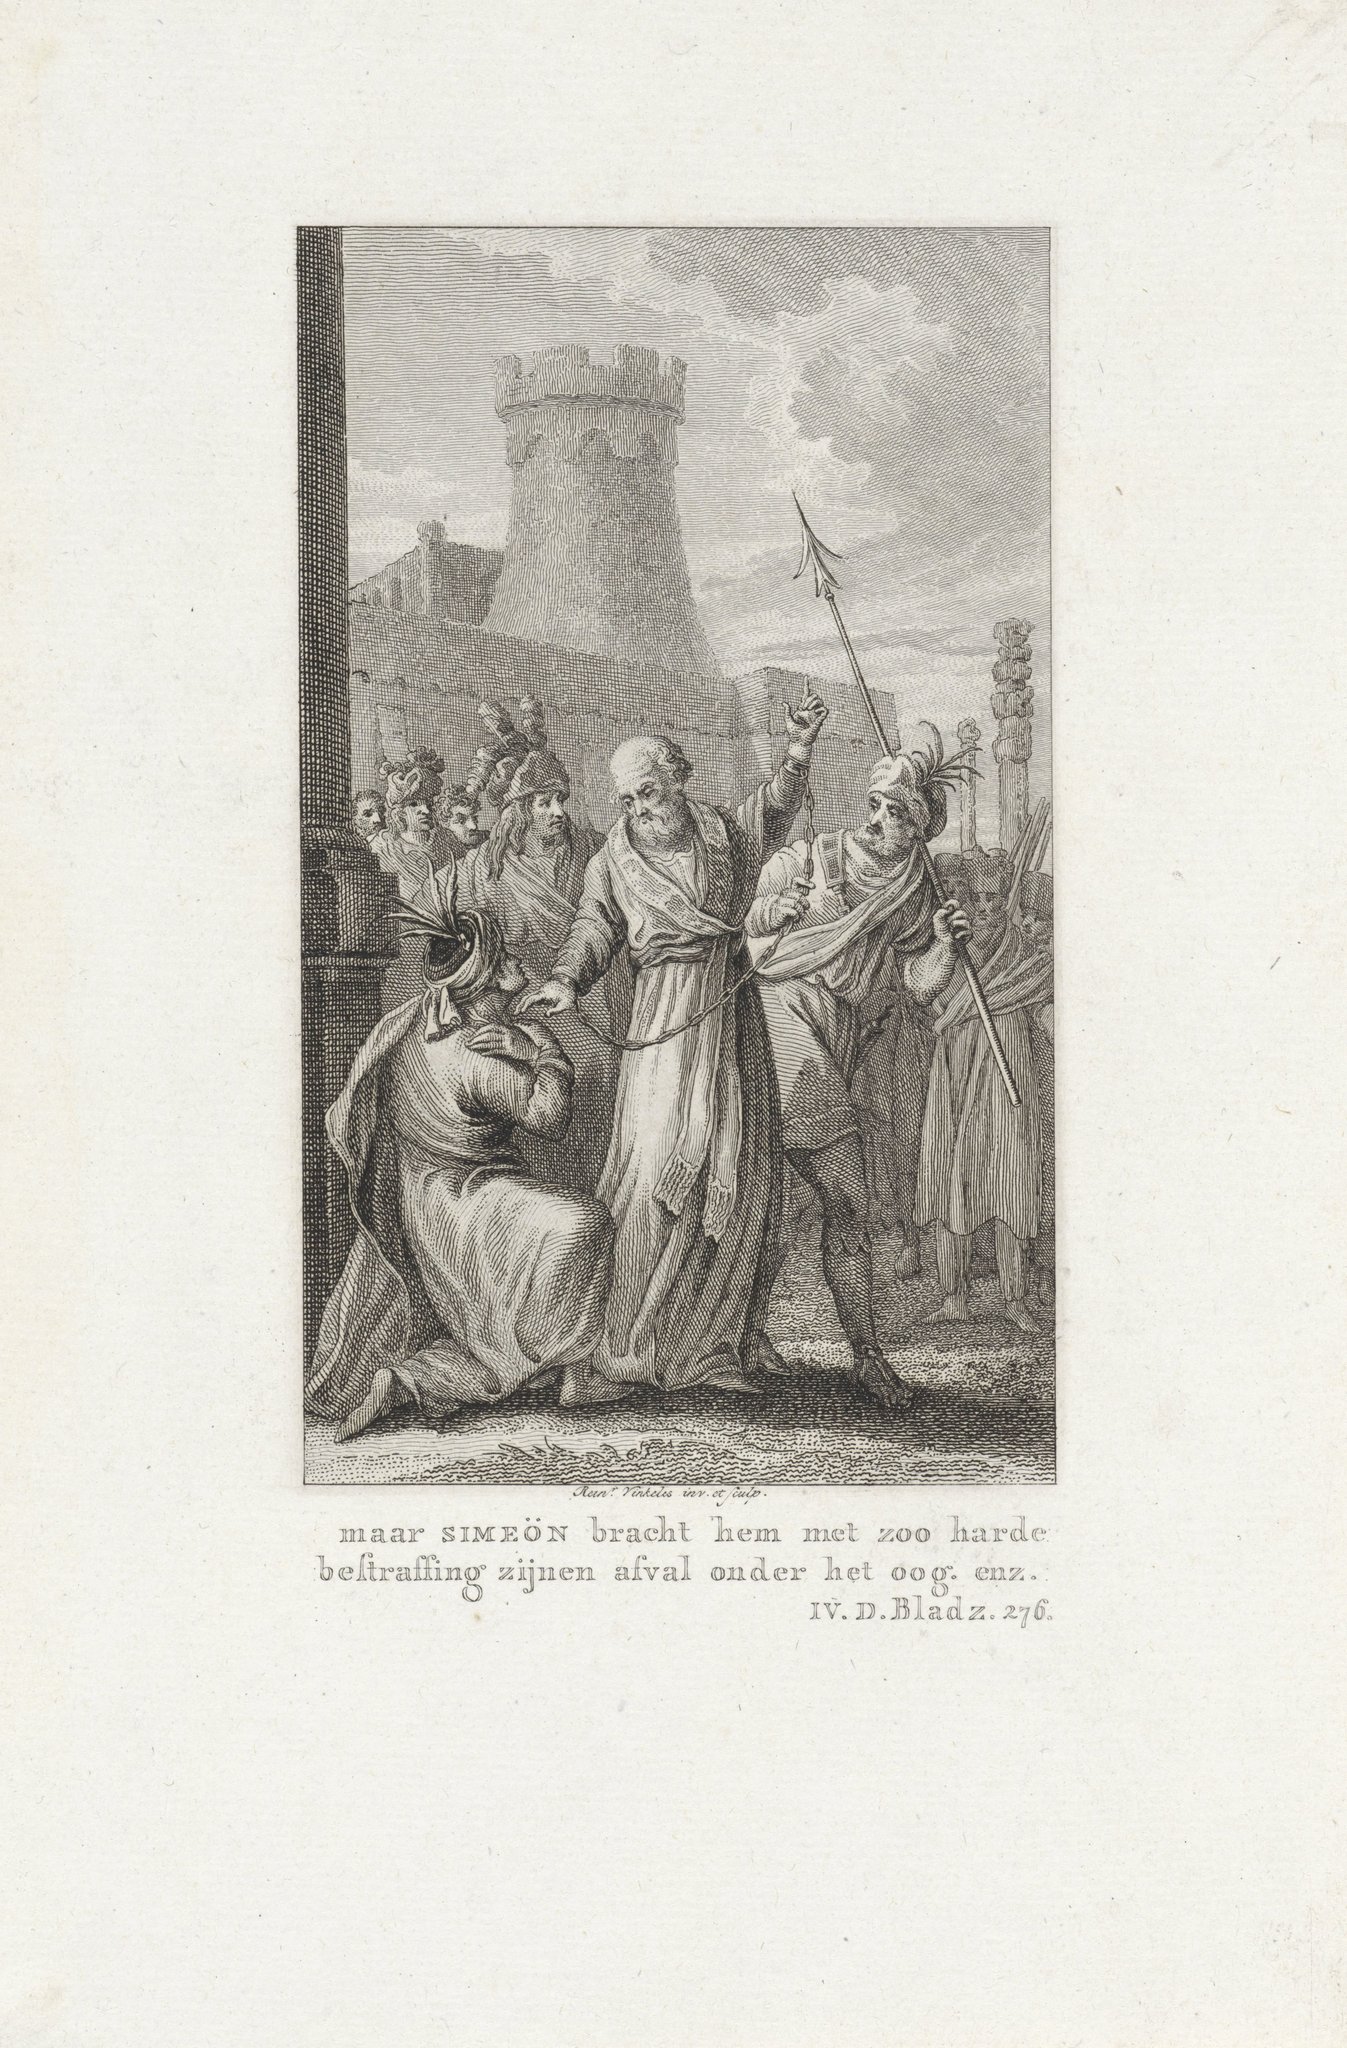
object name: book illustration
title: maar Simeön bracht hem met zoo harde bestraffing zijnen afval onder het oog.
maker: reinier vinkeles (i)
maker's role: draughtsman, print maker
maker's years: 1741-1816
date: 1801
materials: paper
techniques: engraving, etching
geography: amsterdam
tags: archbishop, bishop, etc. (roman catholic), kneeling figure, accusing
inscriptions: collector's mark: Lugt 240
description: Illustratie in: Hamelsveld, Ysbrand van. Algemeene kerkelijke geschiedenis, der Christenen, deel 4. Haarlem: François Bohn, 1801, p. 276.